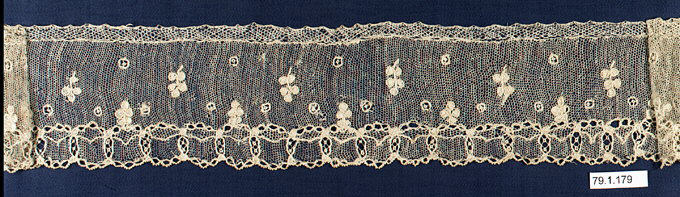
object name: strip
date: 1767-1800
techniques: lace